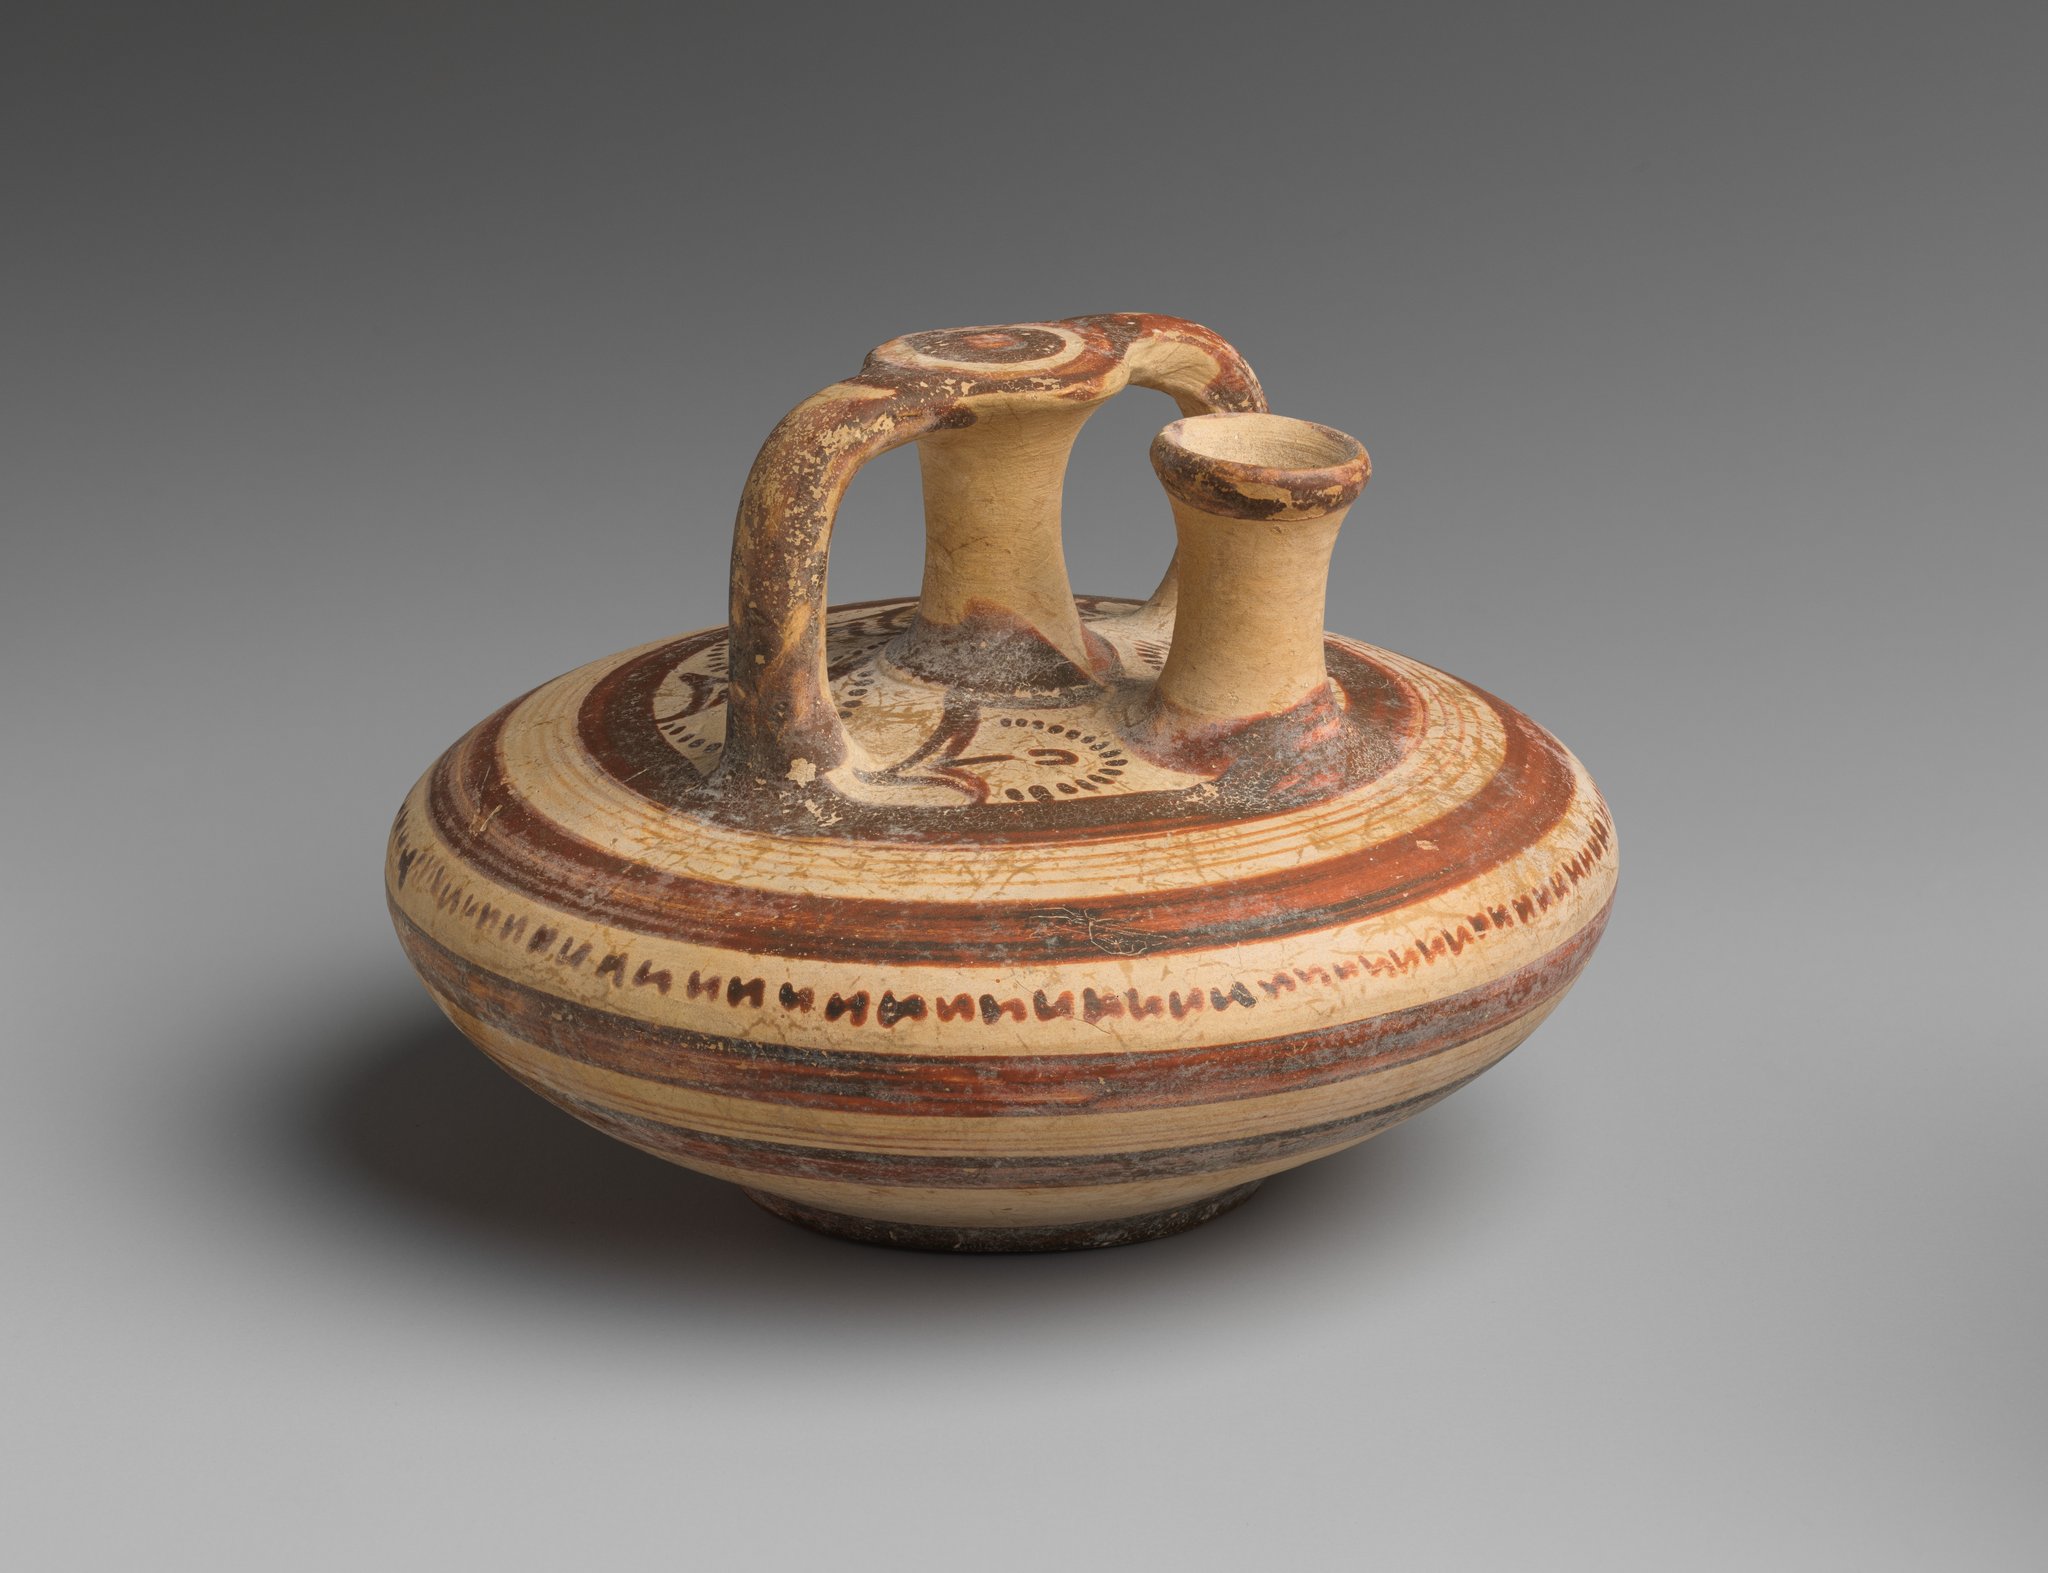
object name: false necked jar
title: Terracotta stirrup jar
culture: mycenaean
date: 1300-1201 BCE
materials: terracotta